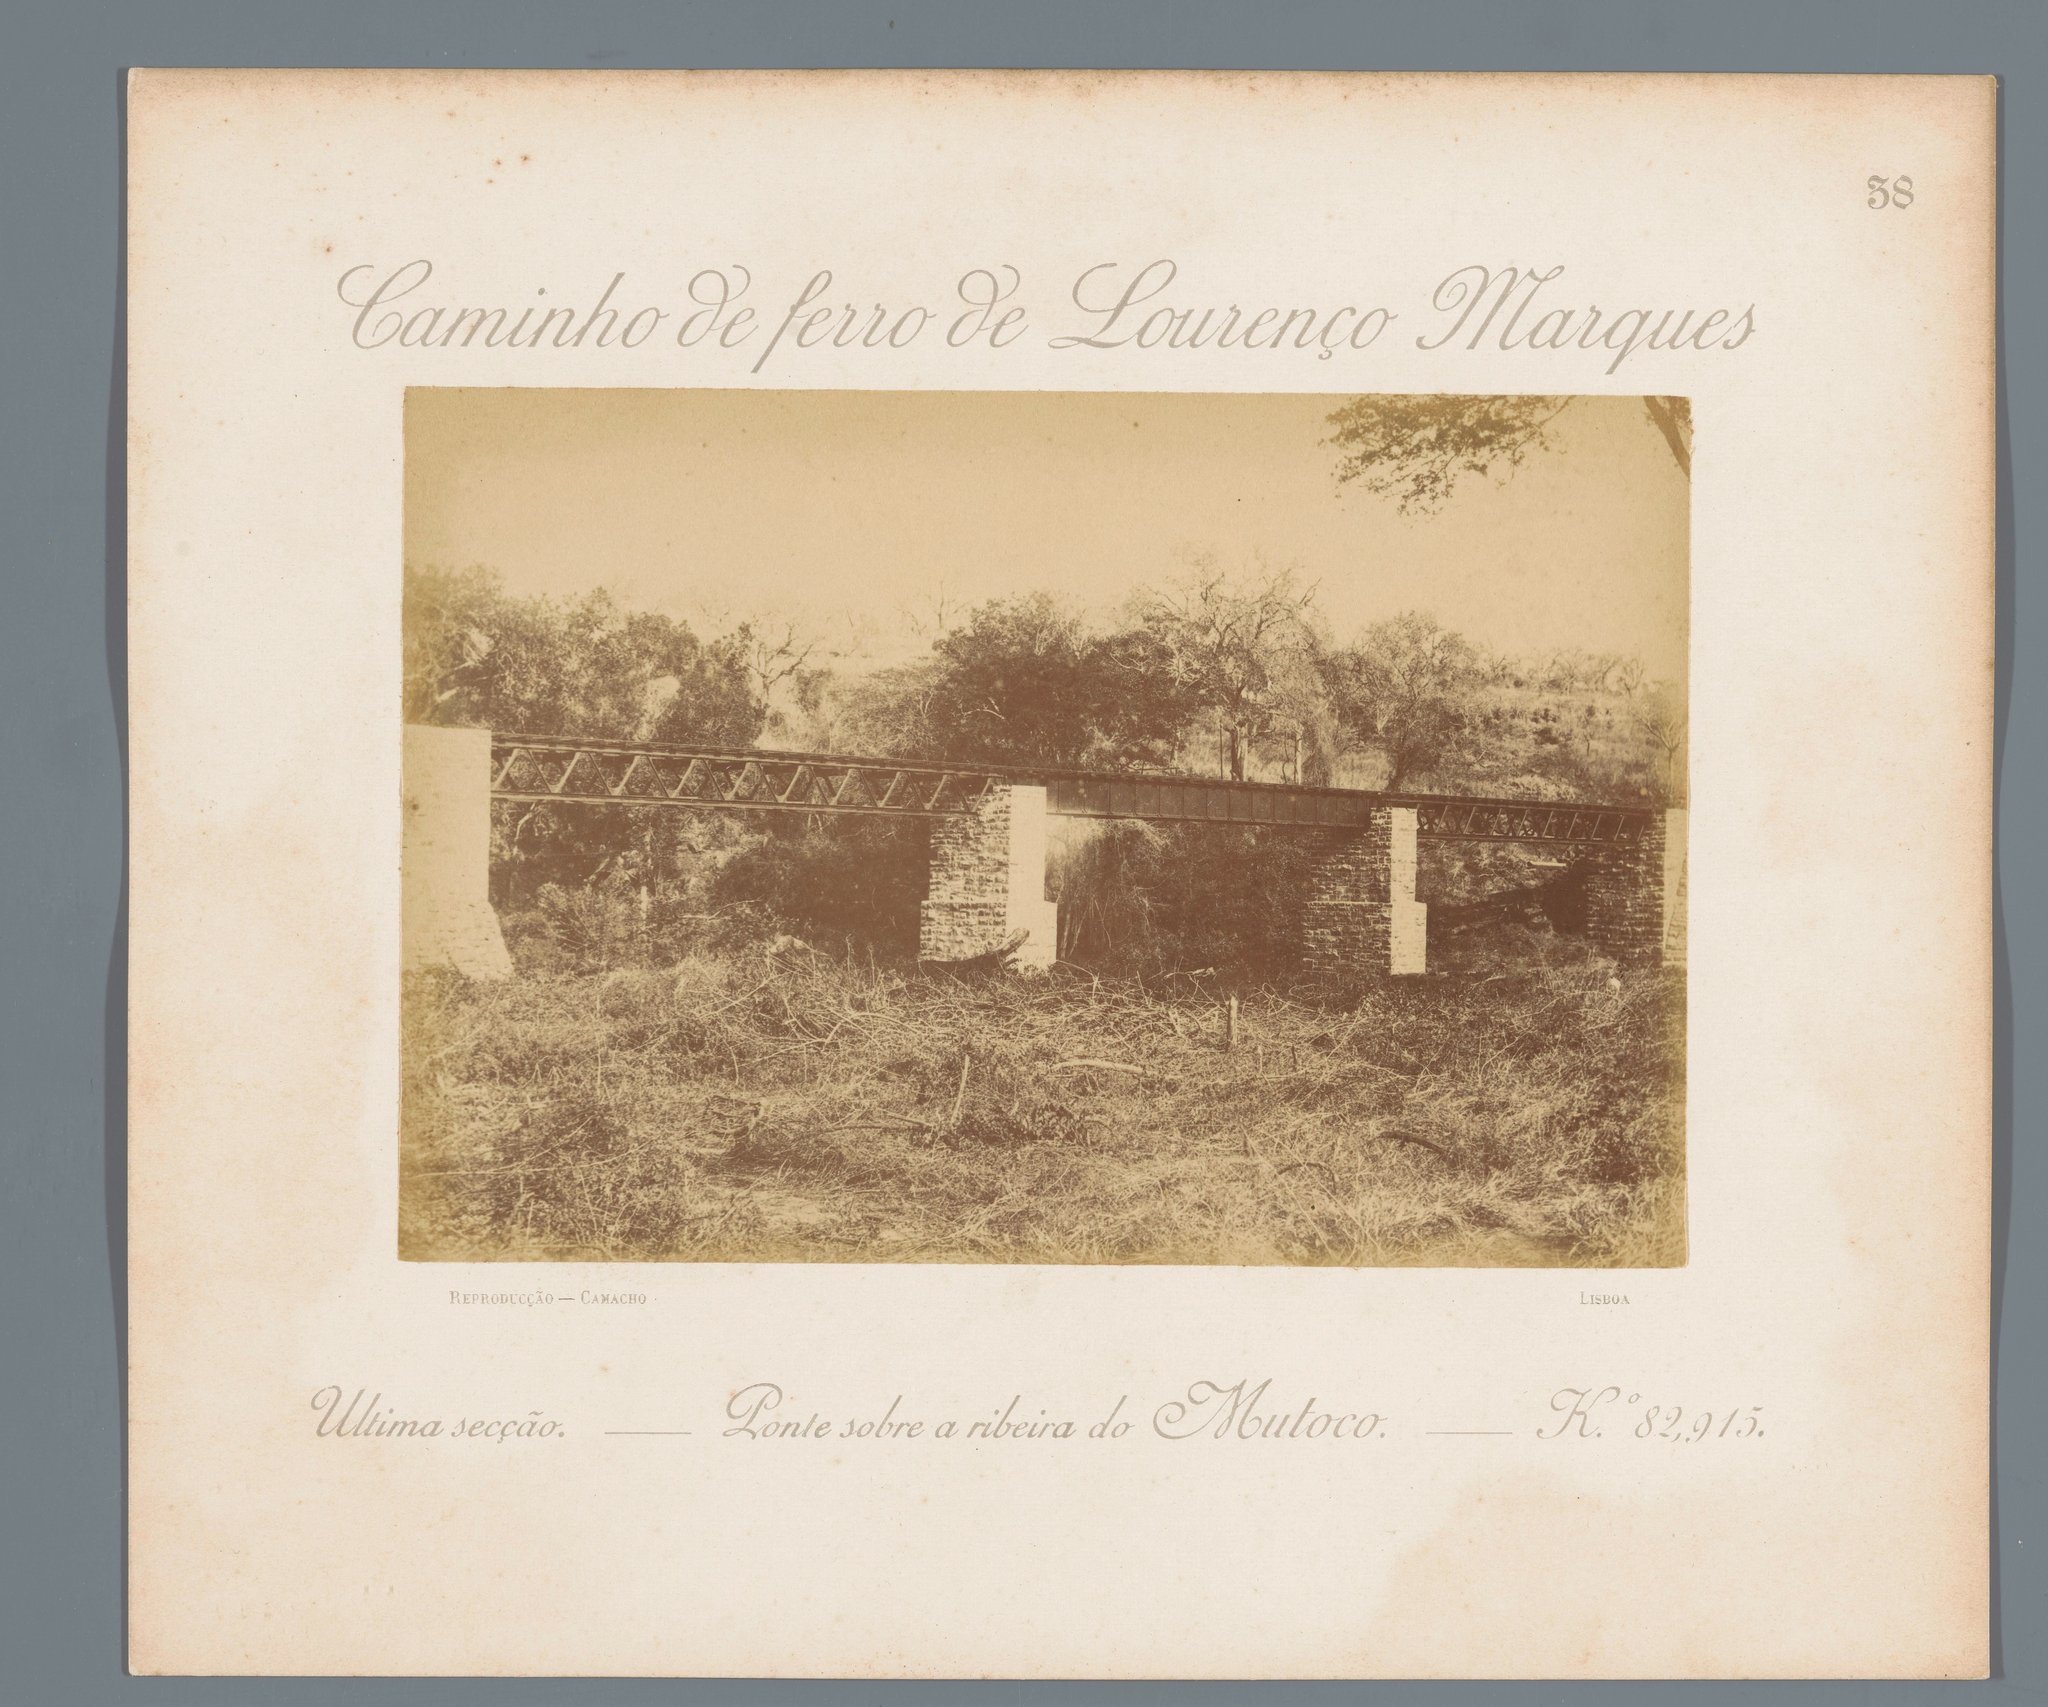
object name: page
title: Ultima secção. - Ponte sobre a ribeira do Mutoco. - K. º82,915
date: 1886-1895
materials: photographic support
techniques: albumen print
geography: lisbon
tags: landscape with bridge, viaduct or aqueduct, railway, train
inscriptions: number: ‘38’